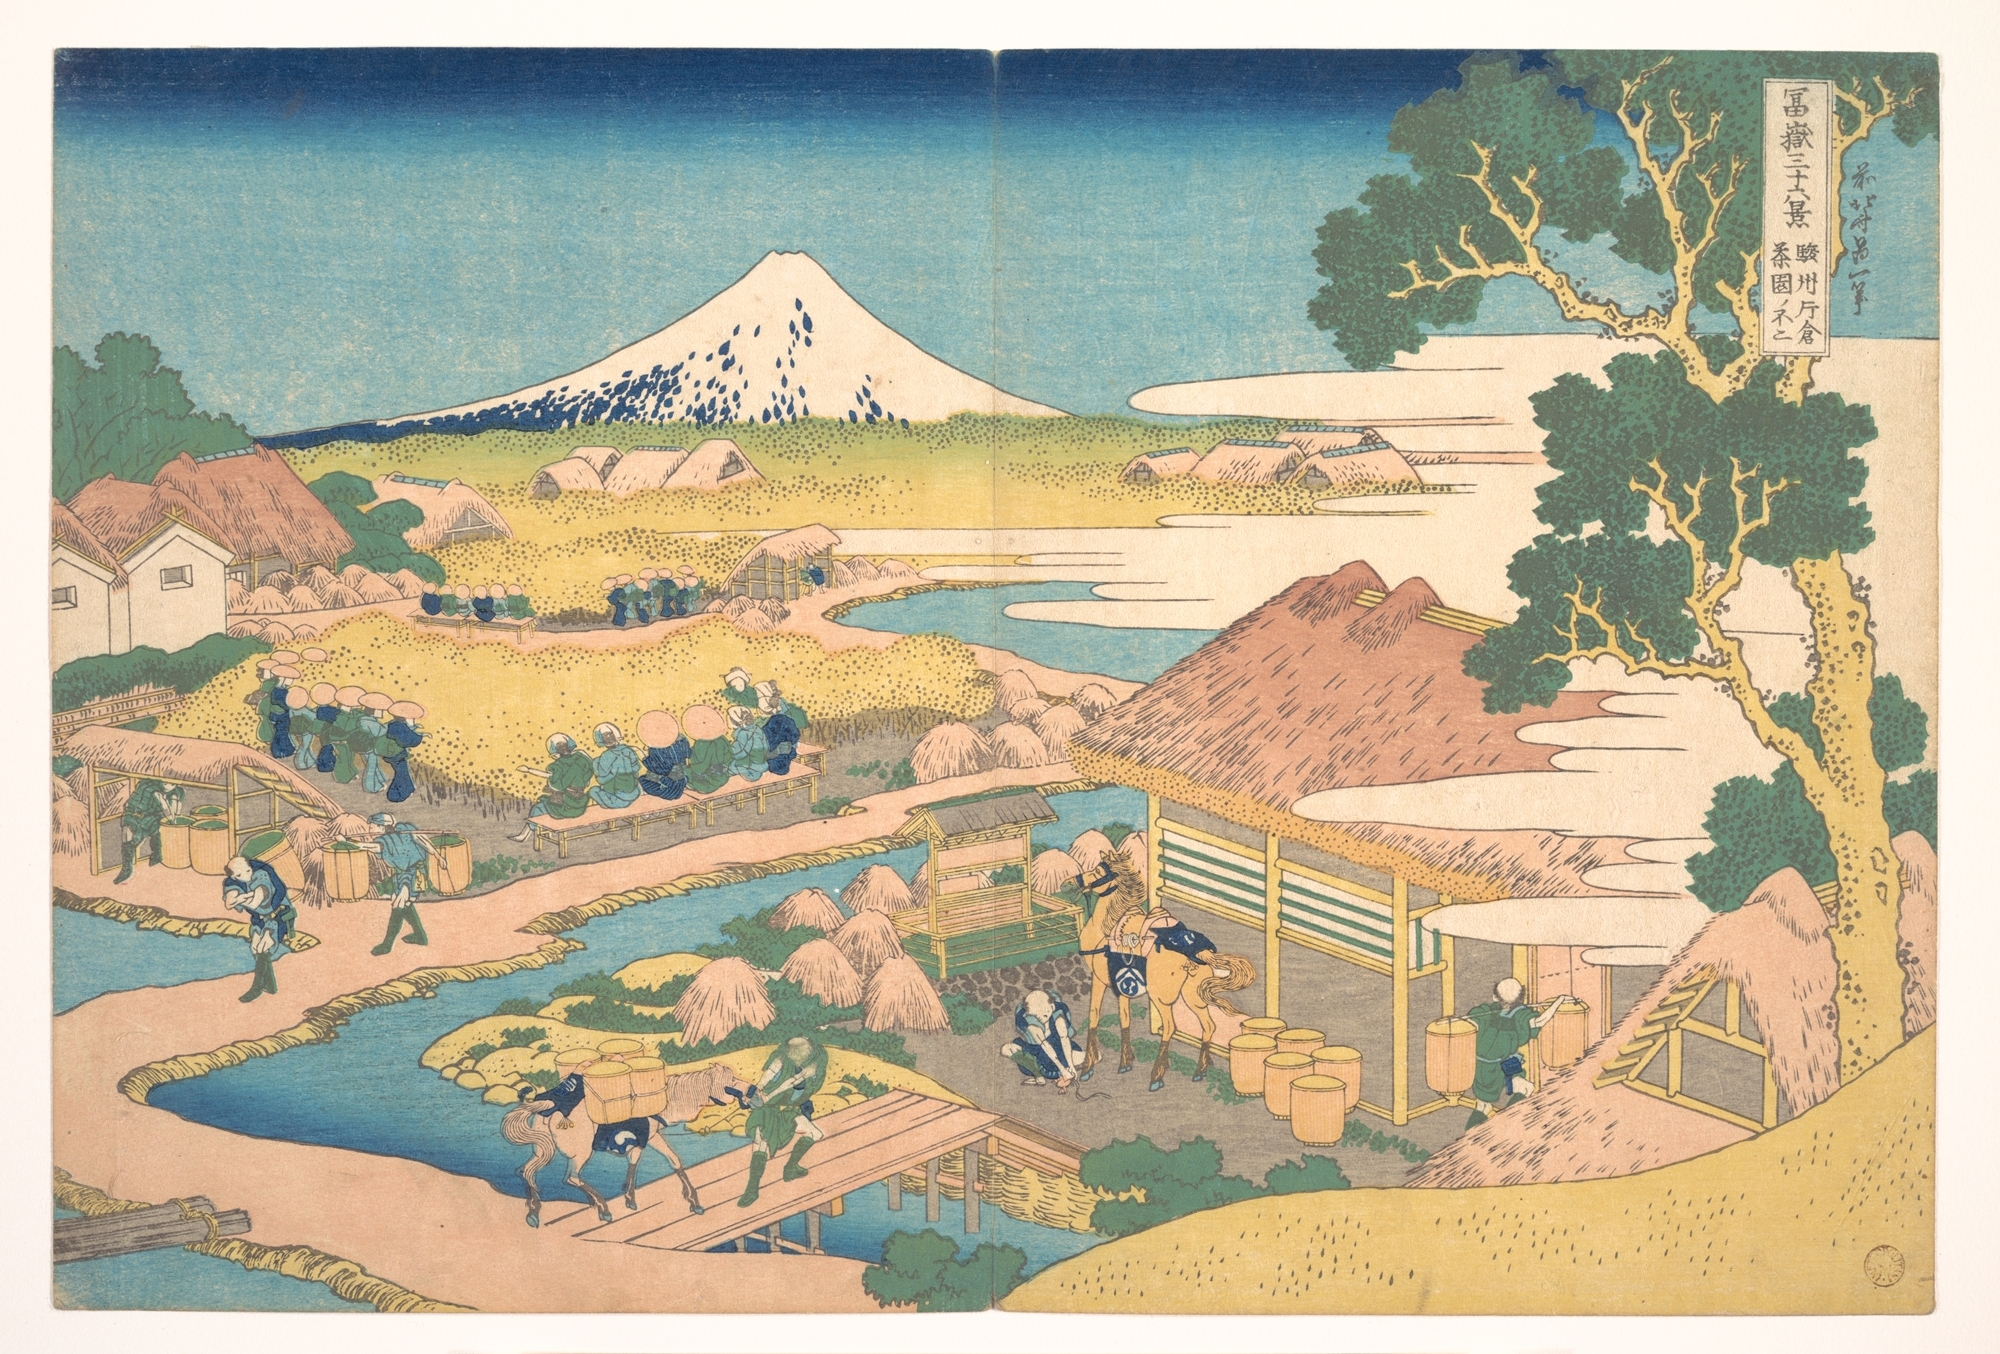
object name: woodblock print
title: Fuji from the Katakura Tea Fields in Suruga (Sunshū Katakura chaen no Fuji), from the series Thirty-six Views of Mount Fuji (Fugaku sanjūrokkei)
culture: japanese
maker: katsushika hokusai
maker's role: artist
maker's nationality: japanese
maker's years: 1760-1849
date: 1830-1832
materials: ink, paper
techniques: woodblock print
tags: human figures,houses,horses,mountains,landscapes